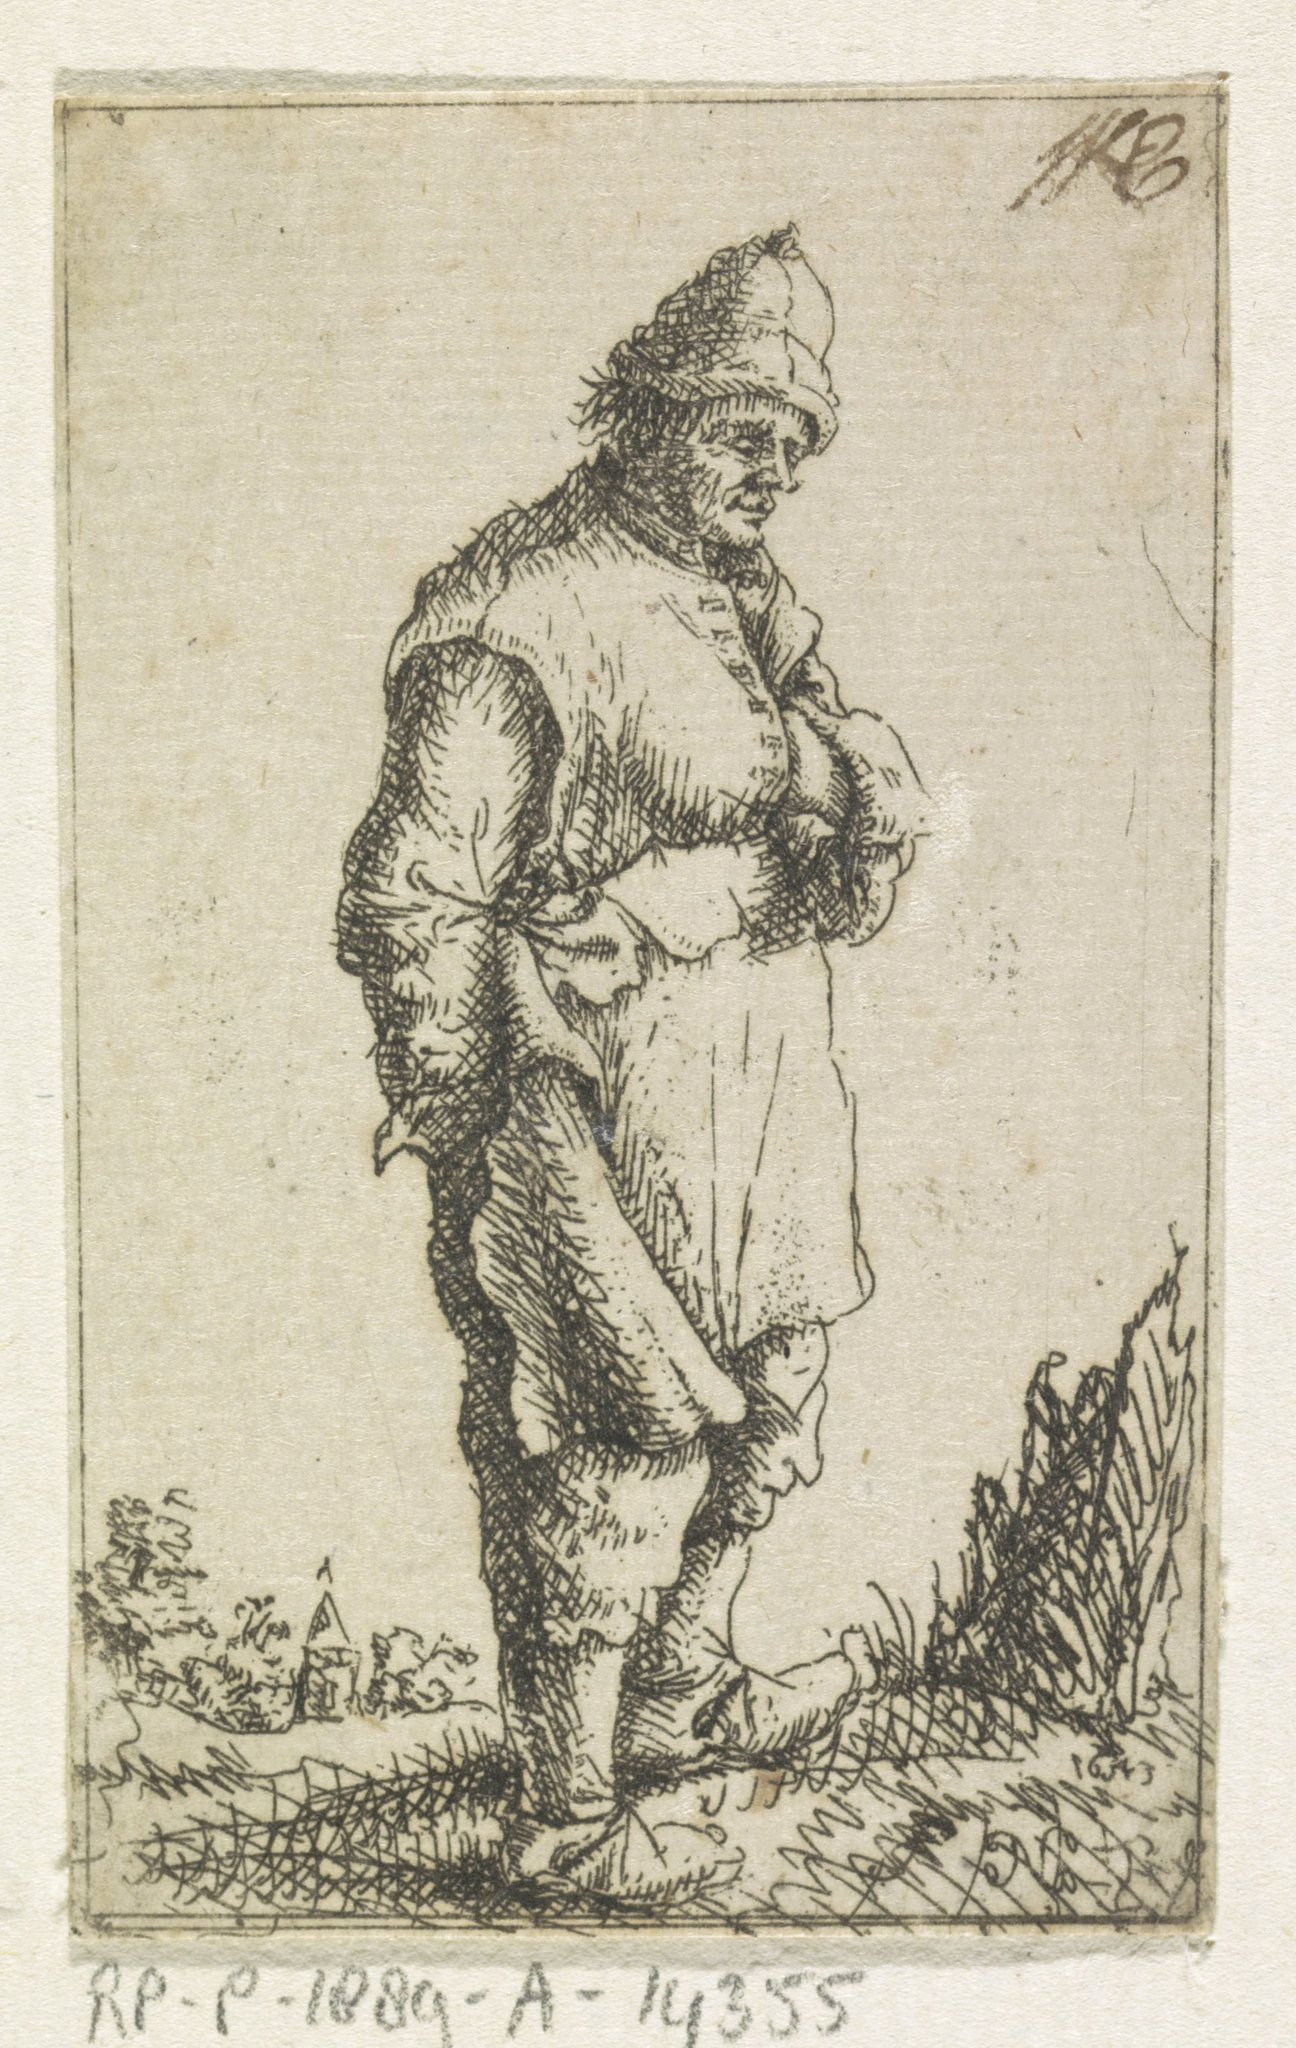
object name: print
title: Staande man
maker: monogrammist ne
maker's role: print maker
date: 1653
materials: paper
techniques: etching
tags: standing figure, adult man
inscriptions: collector's mark: Lugt 2228, collector's mark: ‘19. MayEnahn F 1819’ Lugt 1804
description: Staande man met een hand in zijn jas en de andere hand in zijn broek. Hij draagt een muts op het hoofd. Links aan de horizon een kerktoren.